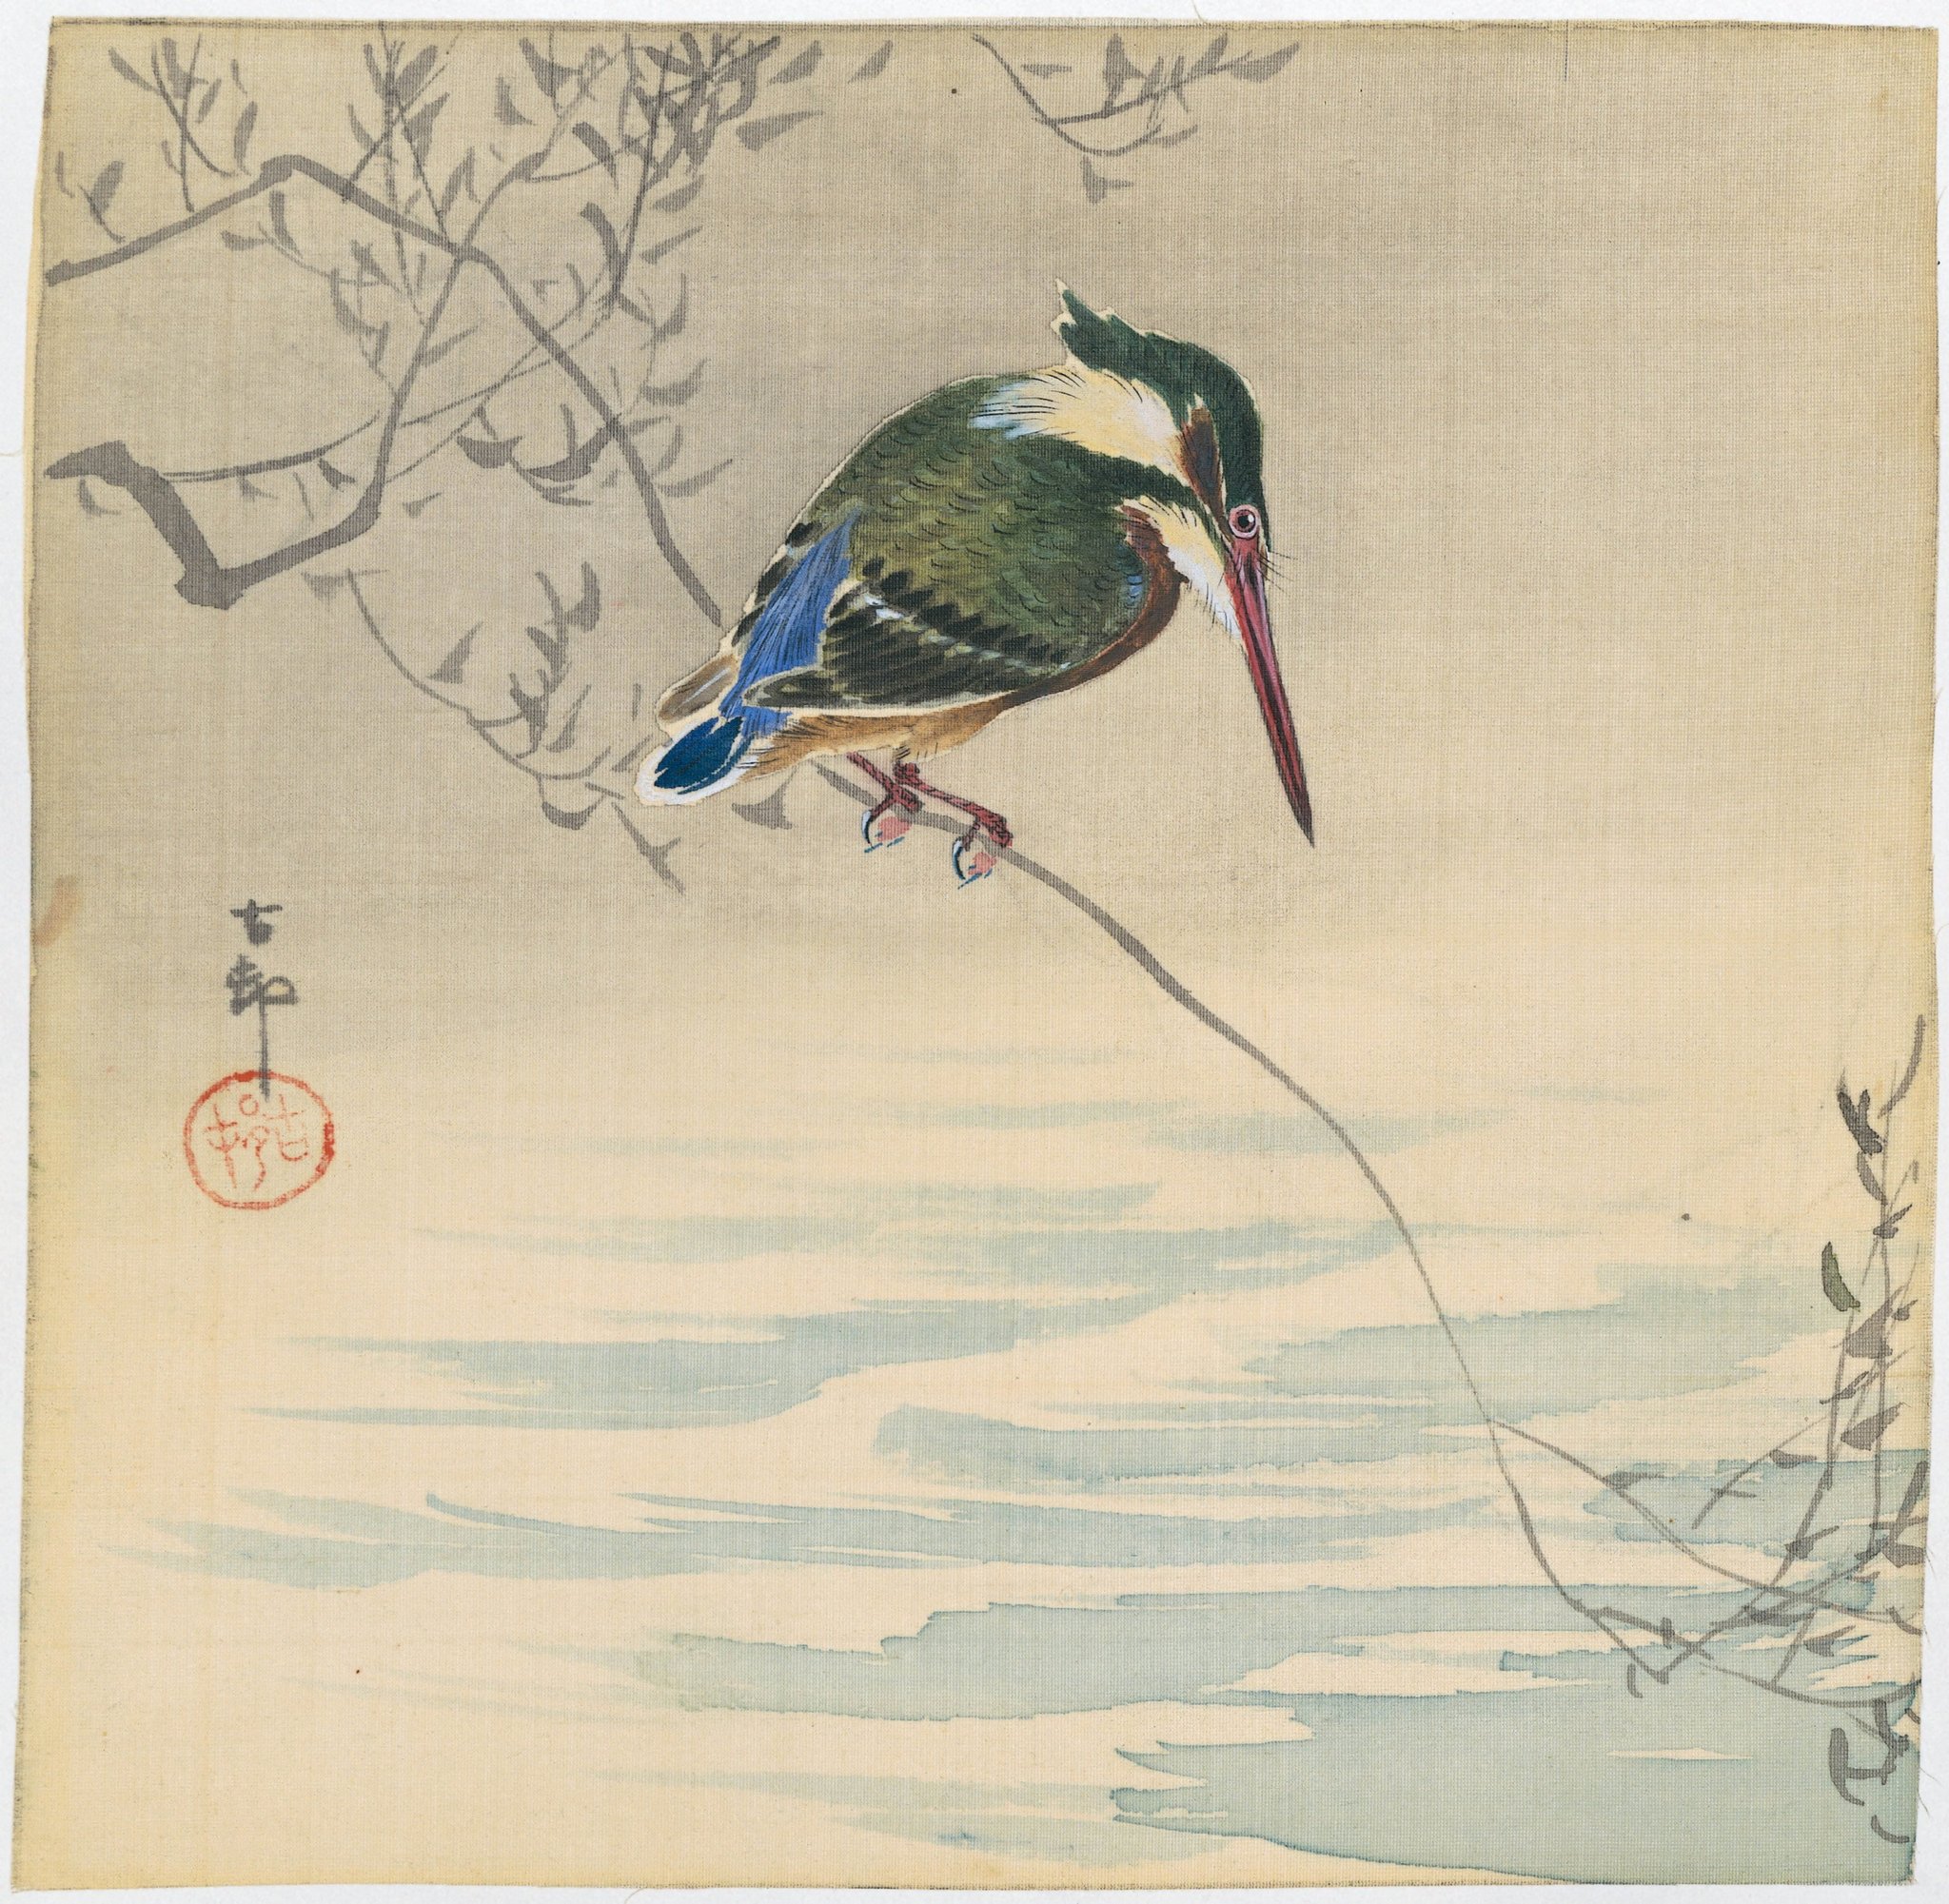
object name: painting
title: Kingfisher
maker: ohara koson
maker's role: print maker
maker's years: 1877-1945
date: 1920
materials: paper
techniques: brush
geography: japan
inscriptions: seal: ‘Koson’, signature: ‘Koson’, seal: ‘Koson’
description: Een ijsvogel zit op een tak boven het water.